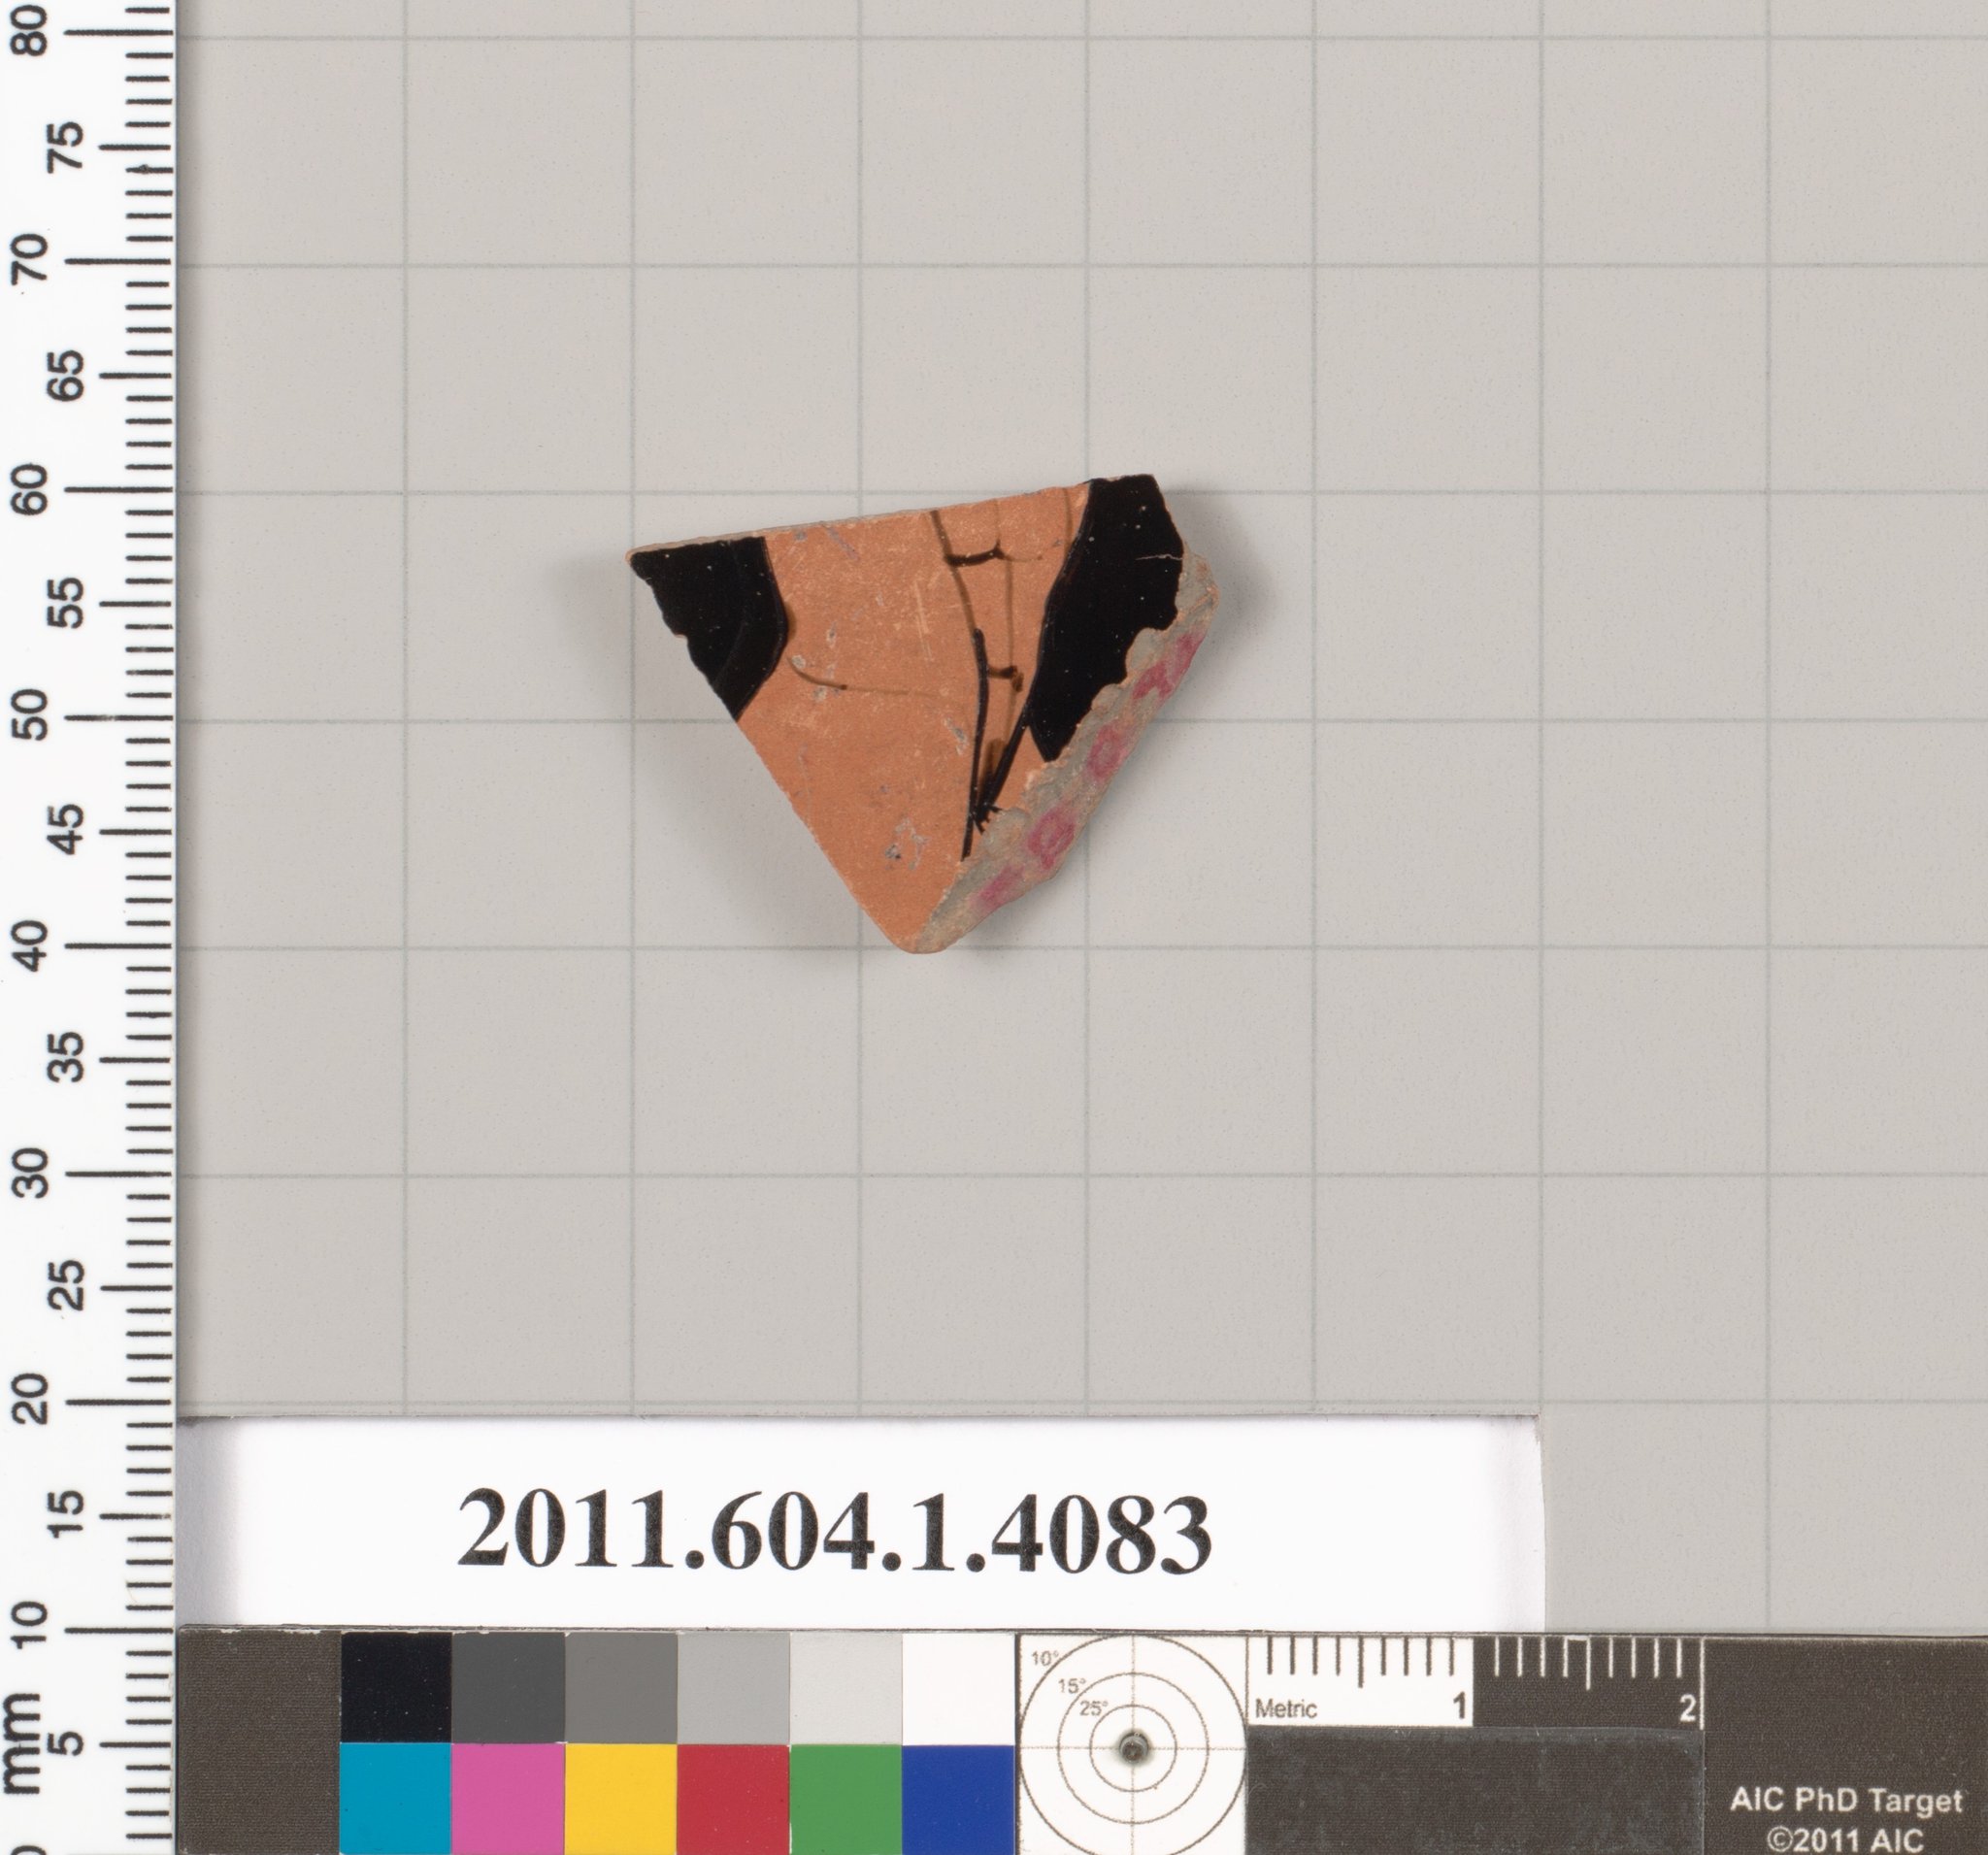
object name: kylix fragment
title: Terracotta fragment of a kylix (drinking cup)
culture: greek, attic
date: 500-480 BCE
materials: terracotta